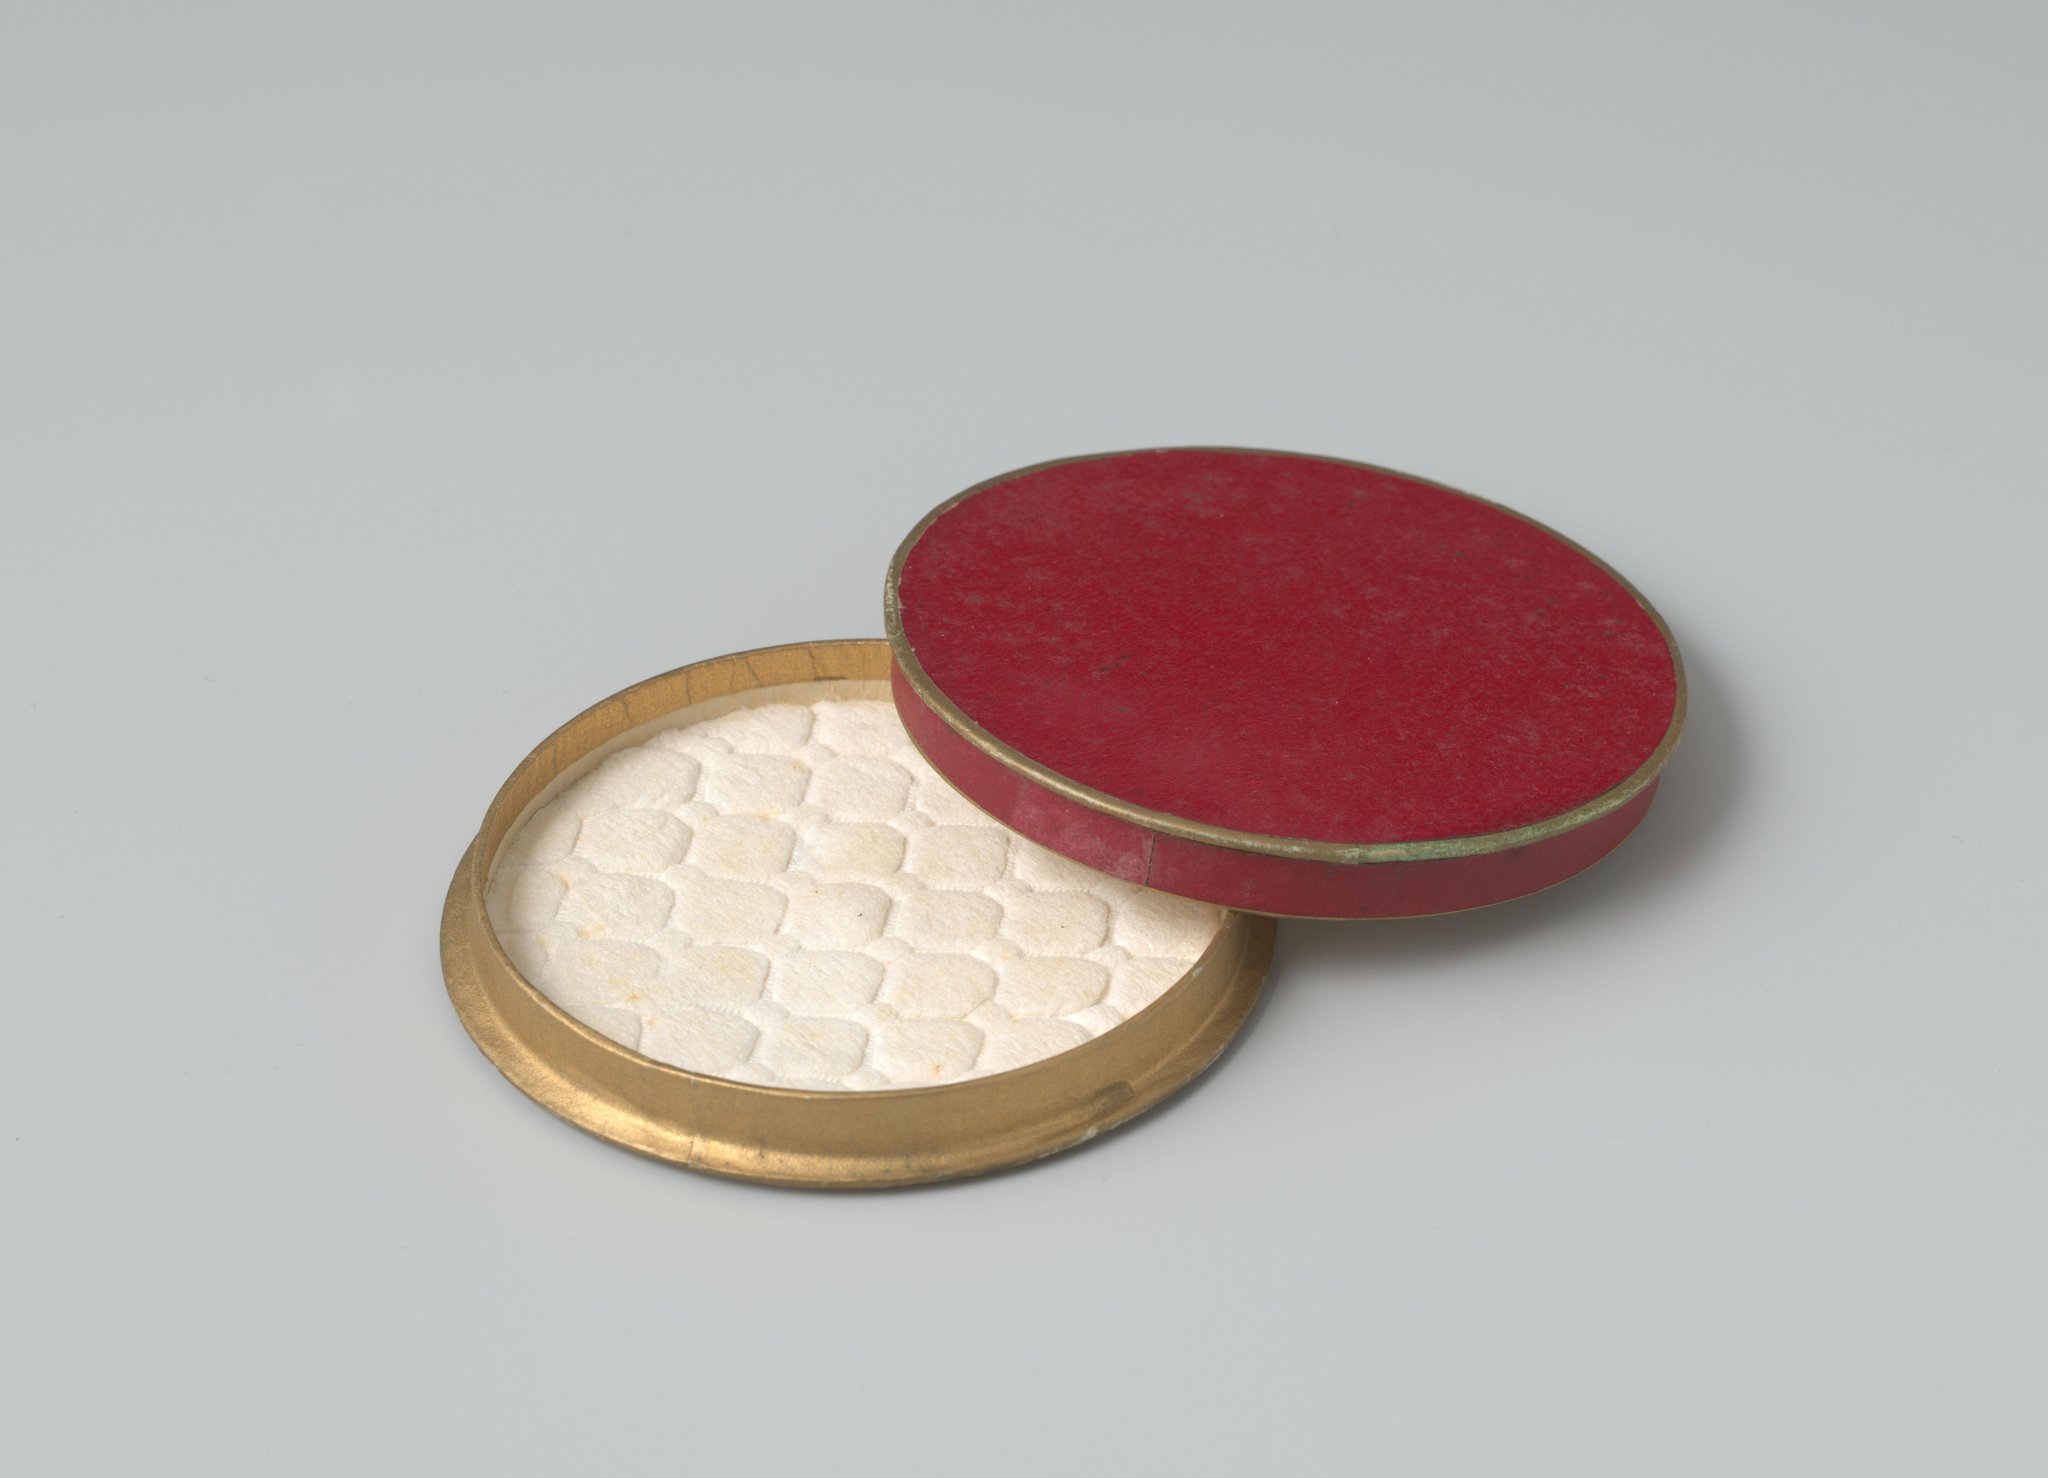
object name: medal box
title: Medal box for the medal on fifty years of existence of the Institute for Tropical Medicine, awarded to Nicolaas Swellengrebel.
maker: arthur dupagne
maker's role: sculptor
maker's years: 1895-1961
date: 1956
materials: cardboard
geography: brussels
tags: laeken, leopold ii (koning der belgen), amsterdam, nicolaas hendrik swellengrebel, antwerp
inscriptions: circumscription: ‘INSTITUUT VOOR TROPISCHE GENEESKUNDE / PRINS LEOPOLD / INSTITUT DE MEDECINE PROPICALE / PRINCE LEOPOLD’, stamp: ‘FONSON’, circumscription: ‘LEOPOLDUS II - REX BELGARUM’, inscription: ‘1906 - 1956’, inscription: ‘PROFESSOR N . SWELLENGREBEL’